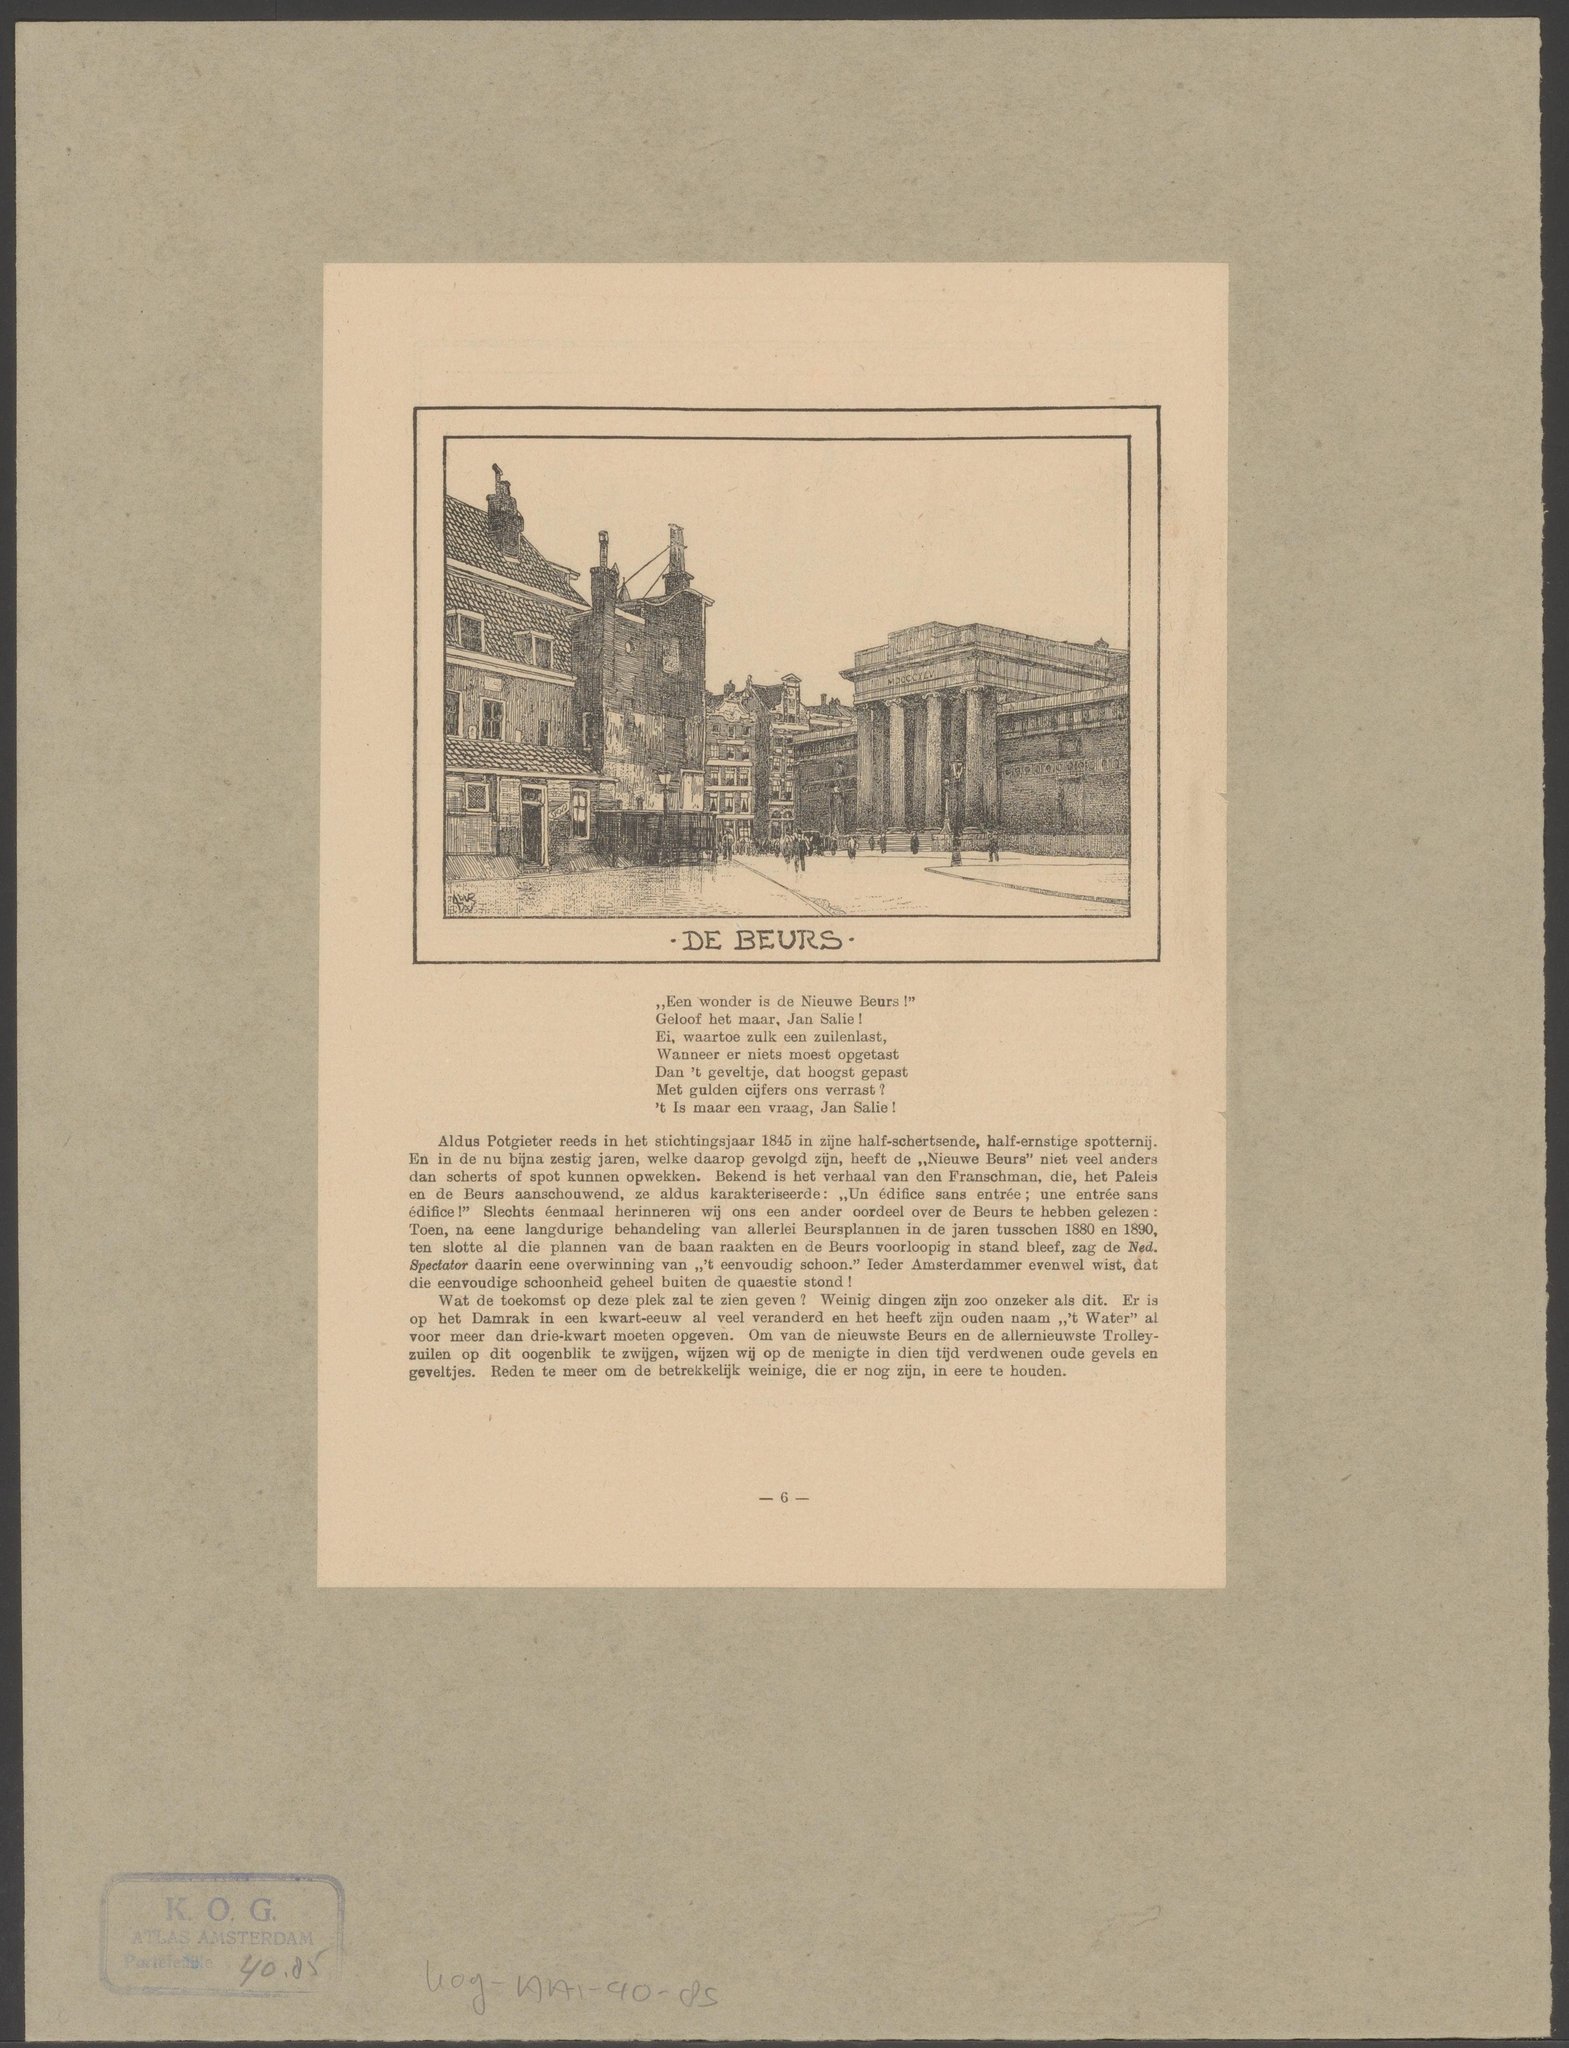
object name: book illustration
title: Gezicht op de Beurs van Zocher te Amsterdam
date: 1907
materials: paper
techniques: letterpress printing, line block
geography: netherlands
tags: stock exchange, stock-market, square, place, circus, etc. (+ city(-scape) with figures, staffage)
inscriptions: collector's mark: Lugt 1641b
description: Prent uit: Oud-Amsterdam. 100 stadsgezichten door L.W.R. Wenckebach. Amsterdam: Het Nieuws van den Dag, 1907, p. 6.